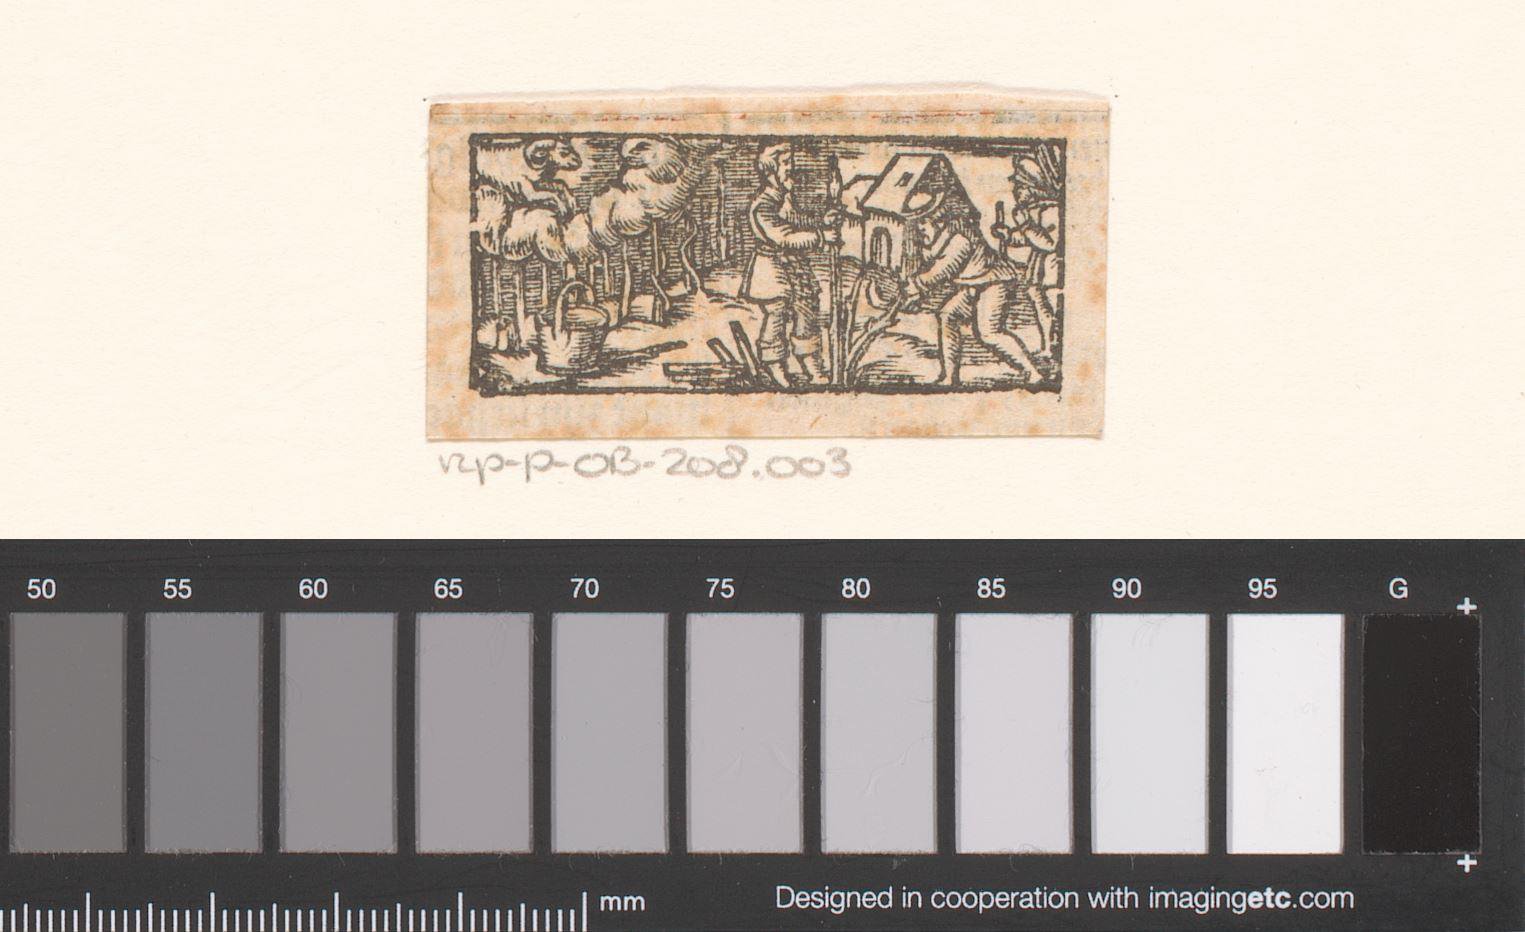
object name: print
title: Maanden van het jaar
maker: Anonymous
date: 1600-1699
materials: paper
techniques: letterpress printing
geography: netherlands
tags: march and its 'labours' (+ with aries (march)), orchard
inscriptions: collector's mark: Lugt 240, collector's mark: Lugt 698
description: Drie mannen werkend bij een boomgaard. Linksboven een ram.